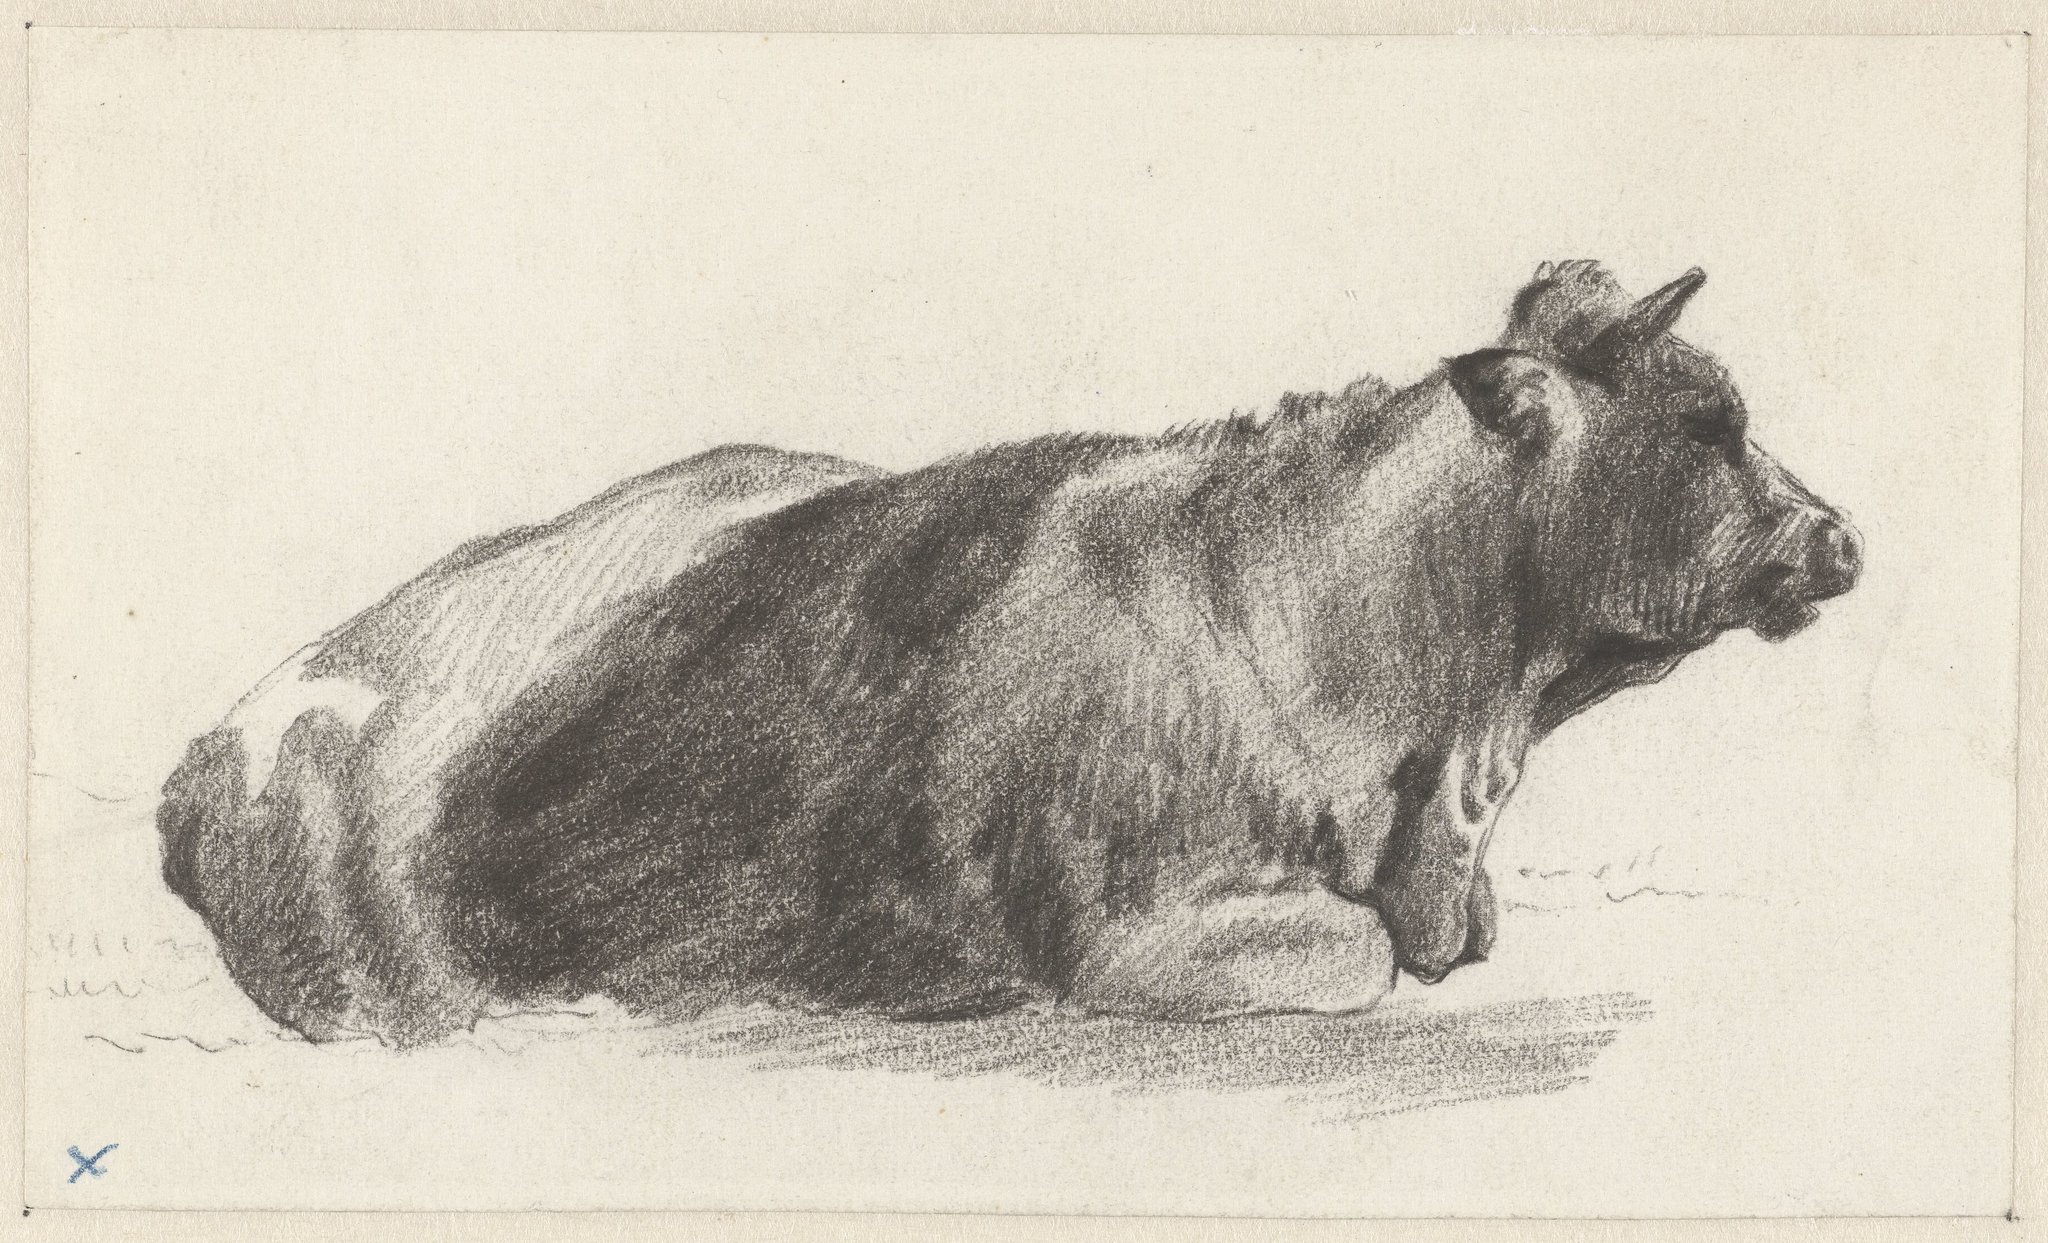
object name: drawing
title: Liggende stier, naar rechts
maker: guillaume anne van der brugghen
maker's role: draughtsman, print maker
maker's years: 1812-1891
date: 1821-1890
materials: chalk, paper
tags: cow